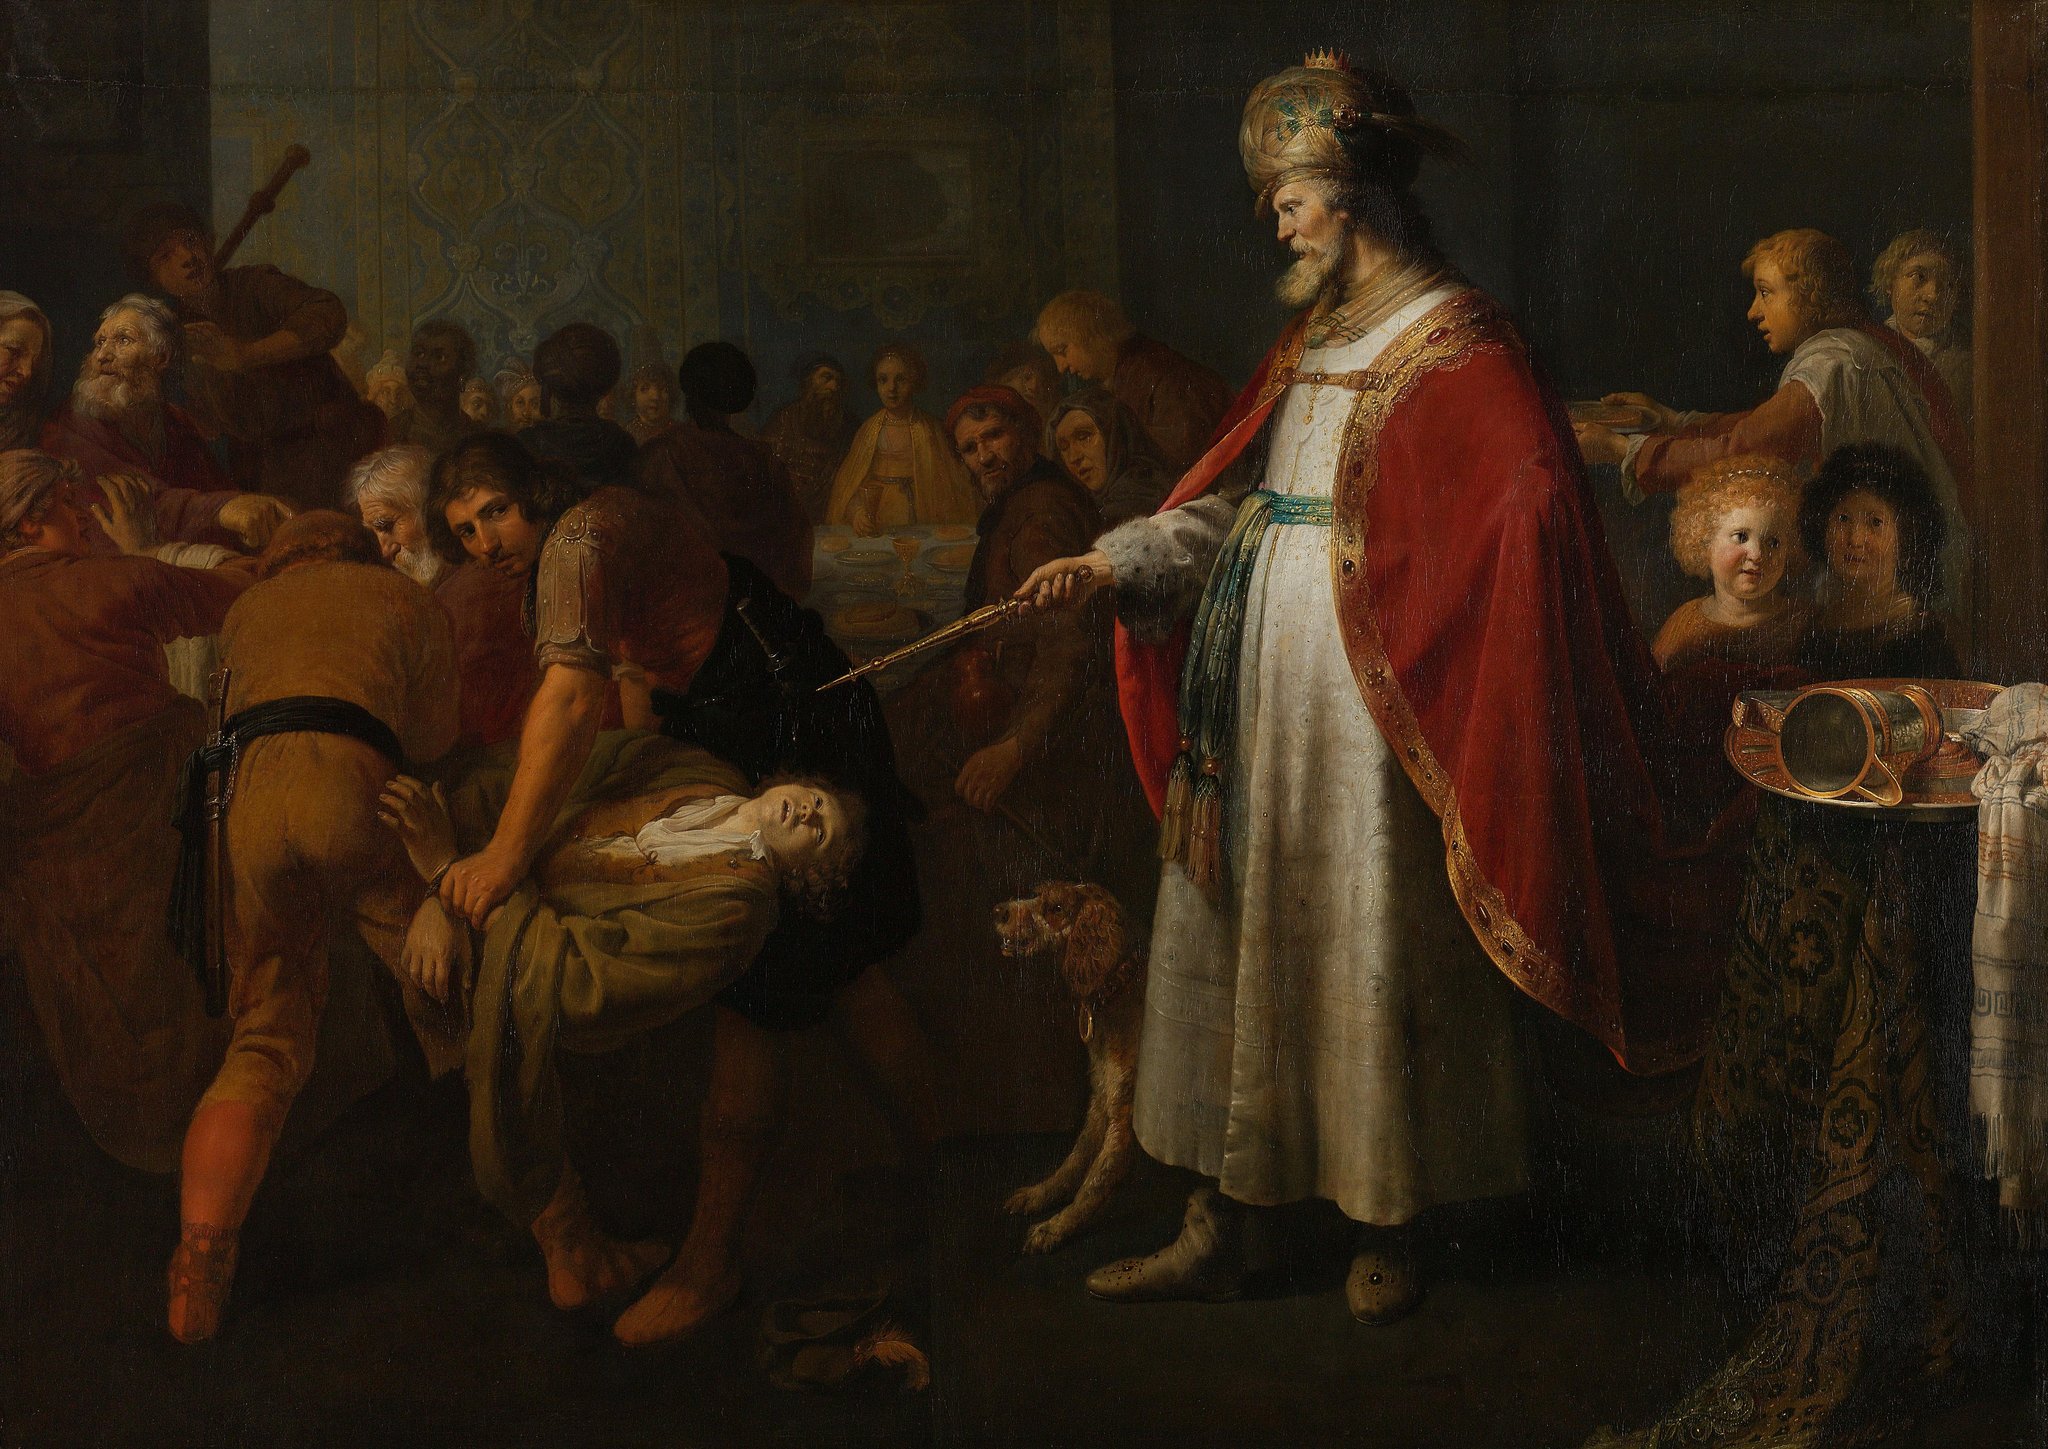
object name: painting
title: The Parable of the Unworthy Wedding Guest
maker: simon kick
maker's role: draughtsman, painter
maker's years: 1603-1652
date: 1644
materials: canvas, oil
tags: the king sees a guest without a wedding garment: 'bind him hand and foot .. and cast him into the outer darkness' ~ parable of the royal wedding-feast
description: De gelijkenis van de onwaardige bruiloftsgast. De koning laat de gast uit de zaal verwijderen. Op de achtergrond zit de bruid met gasten aan tafel.